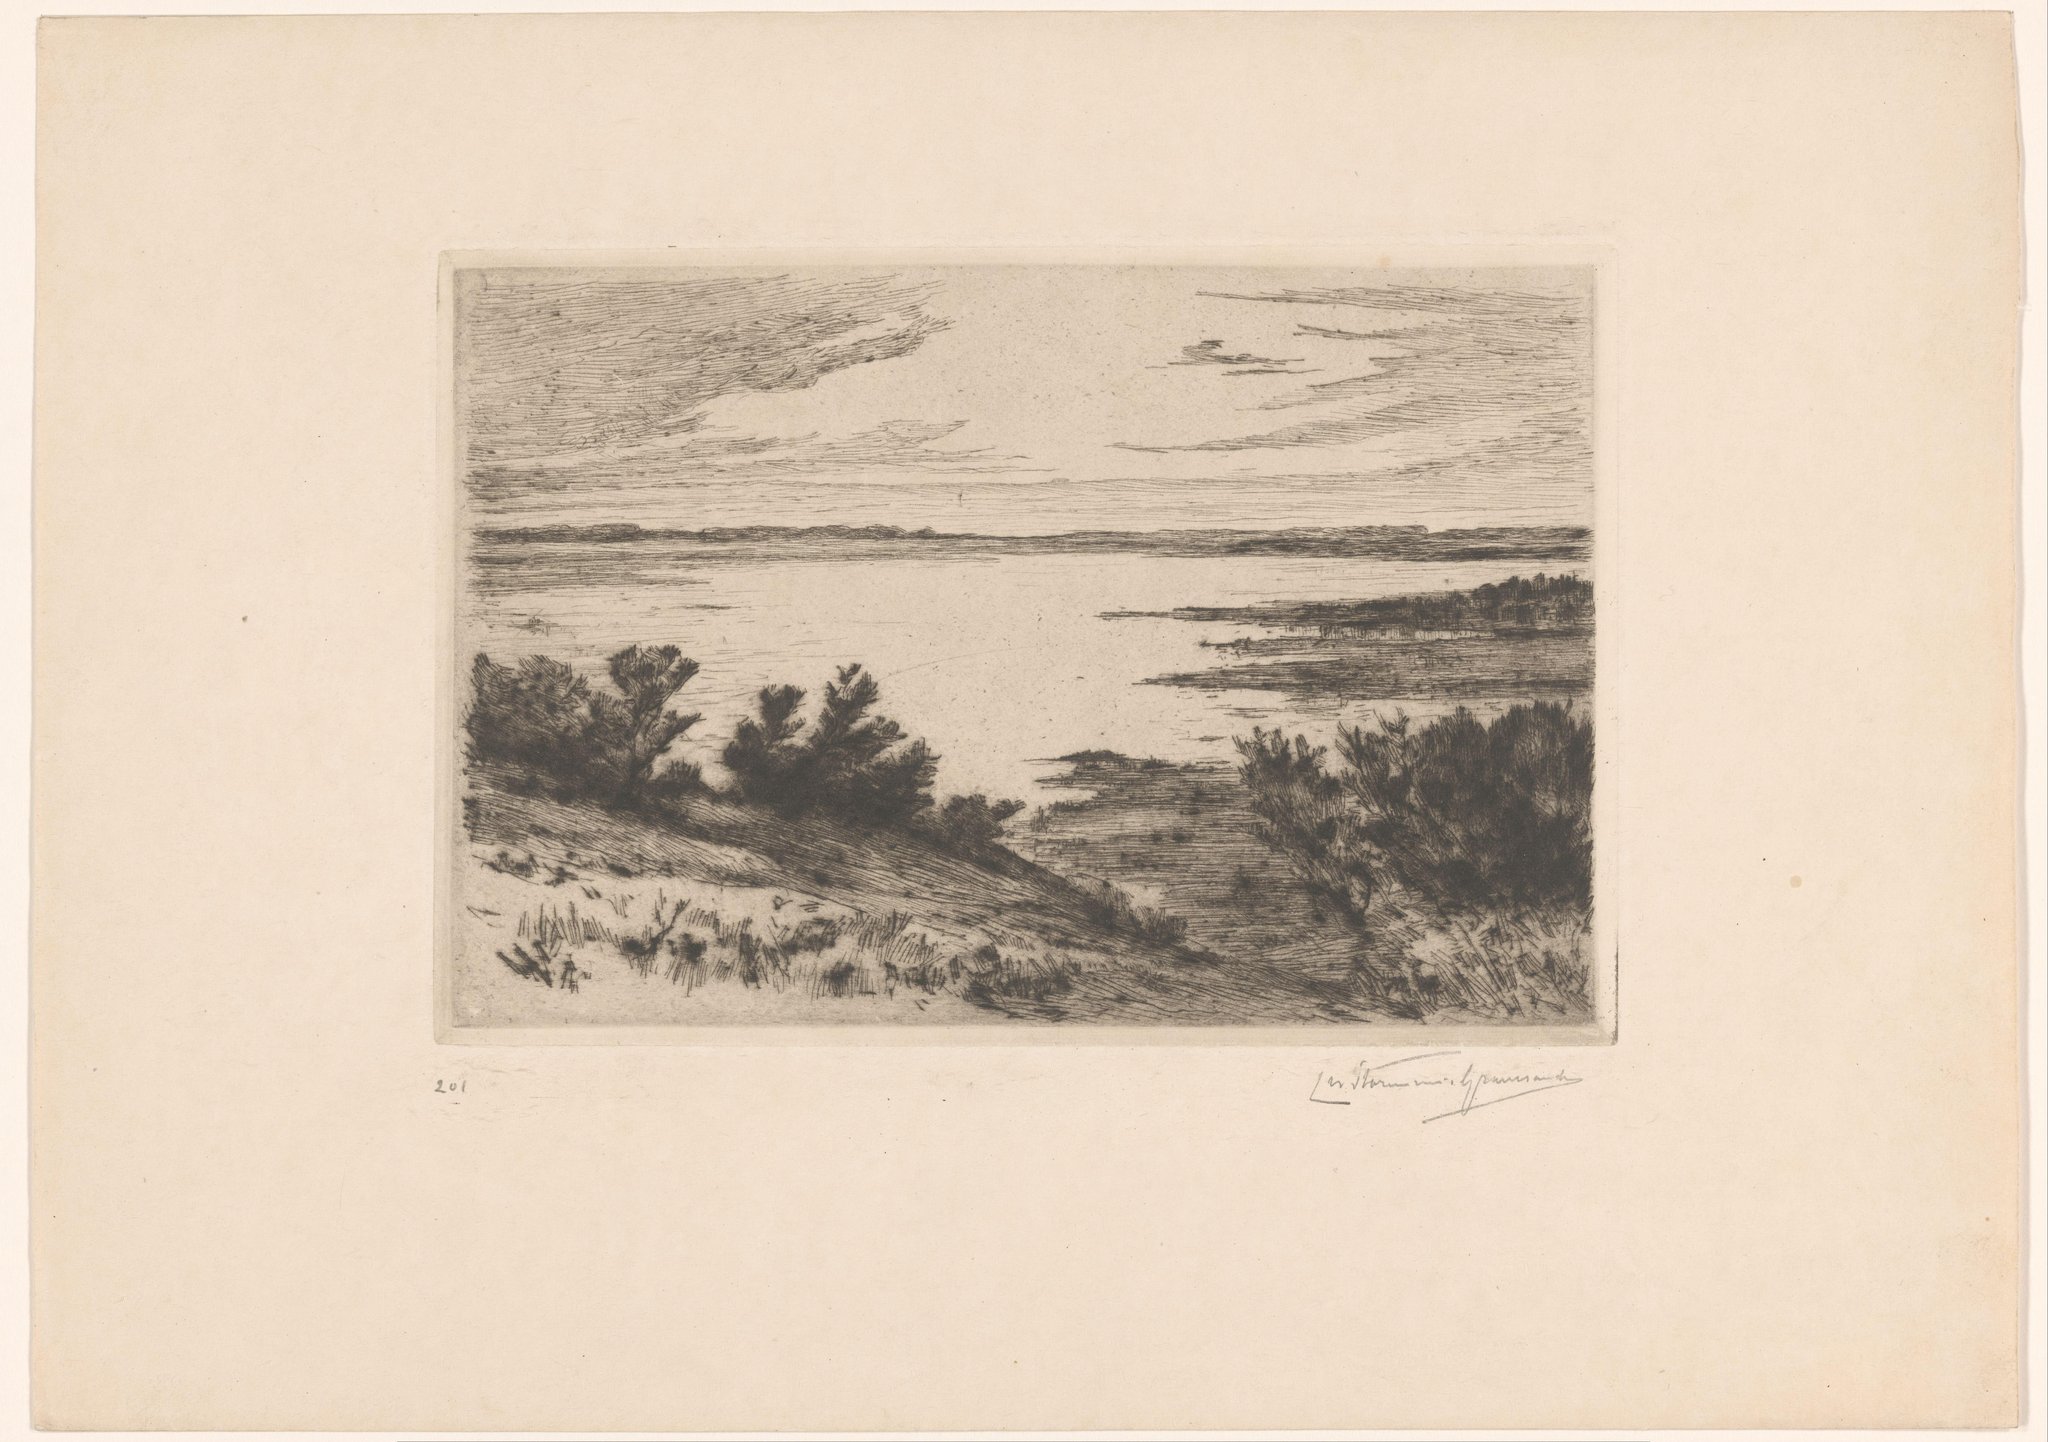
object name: print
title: Gezicht op een meer bij Bergen op Zoom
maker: carel nicolaas storm van s-gravesande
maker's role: draughtsman, print maker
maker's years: 1841-1924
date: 1884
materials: paper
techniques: drypoint, intaglio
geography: netherlands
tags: lake, bergen op zoom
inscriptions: collector's mark: Lugt 2228